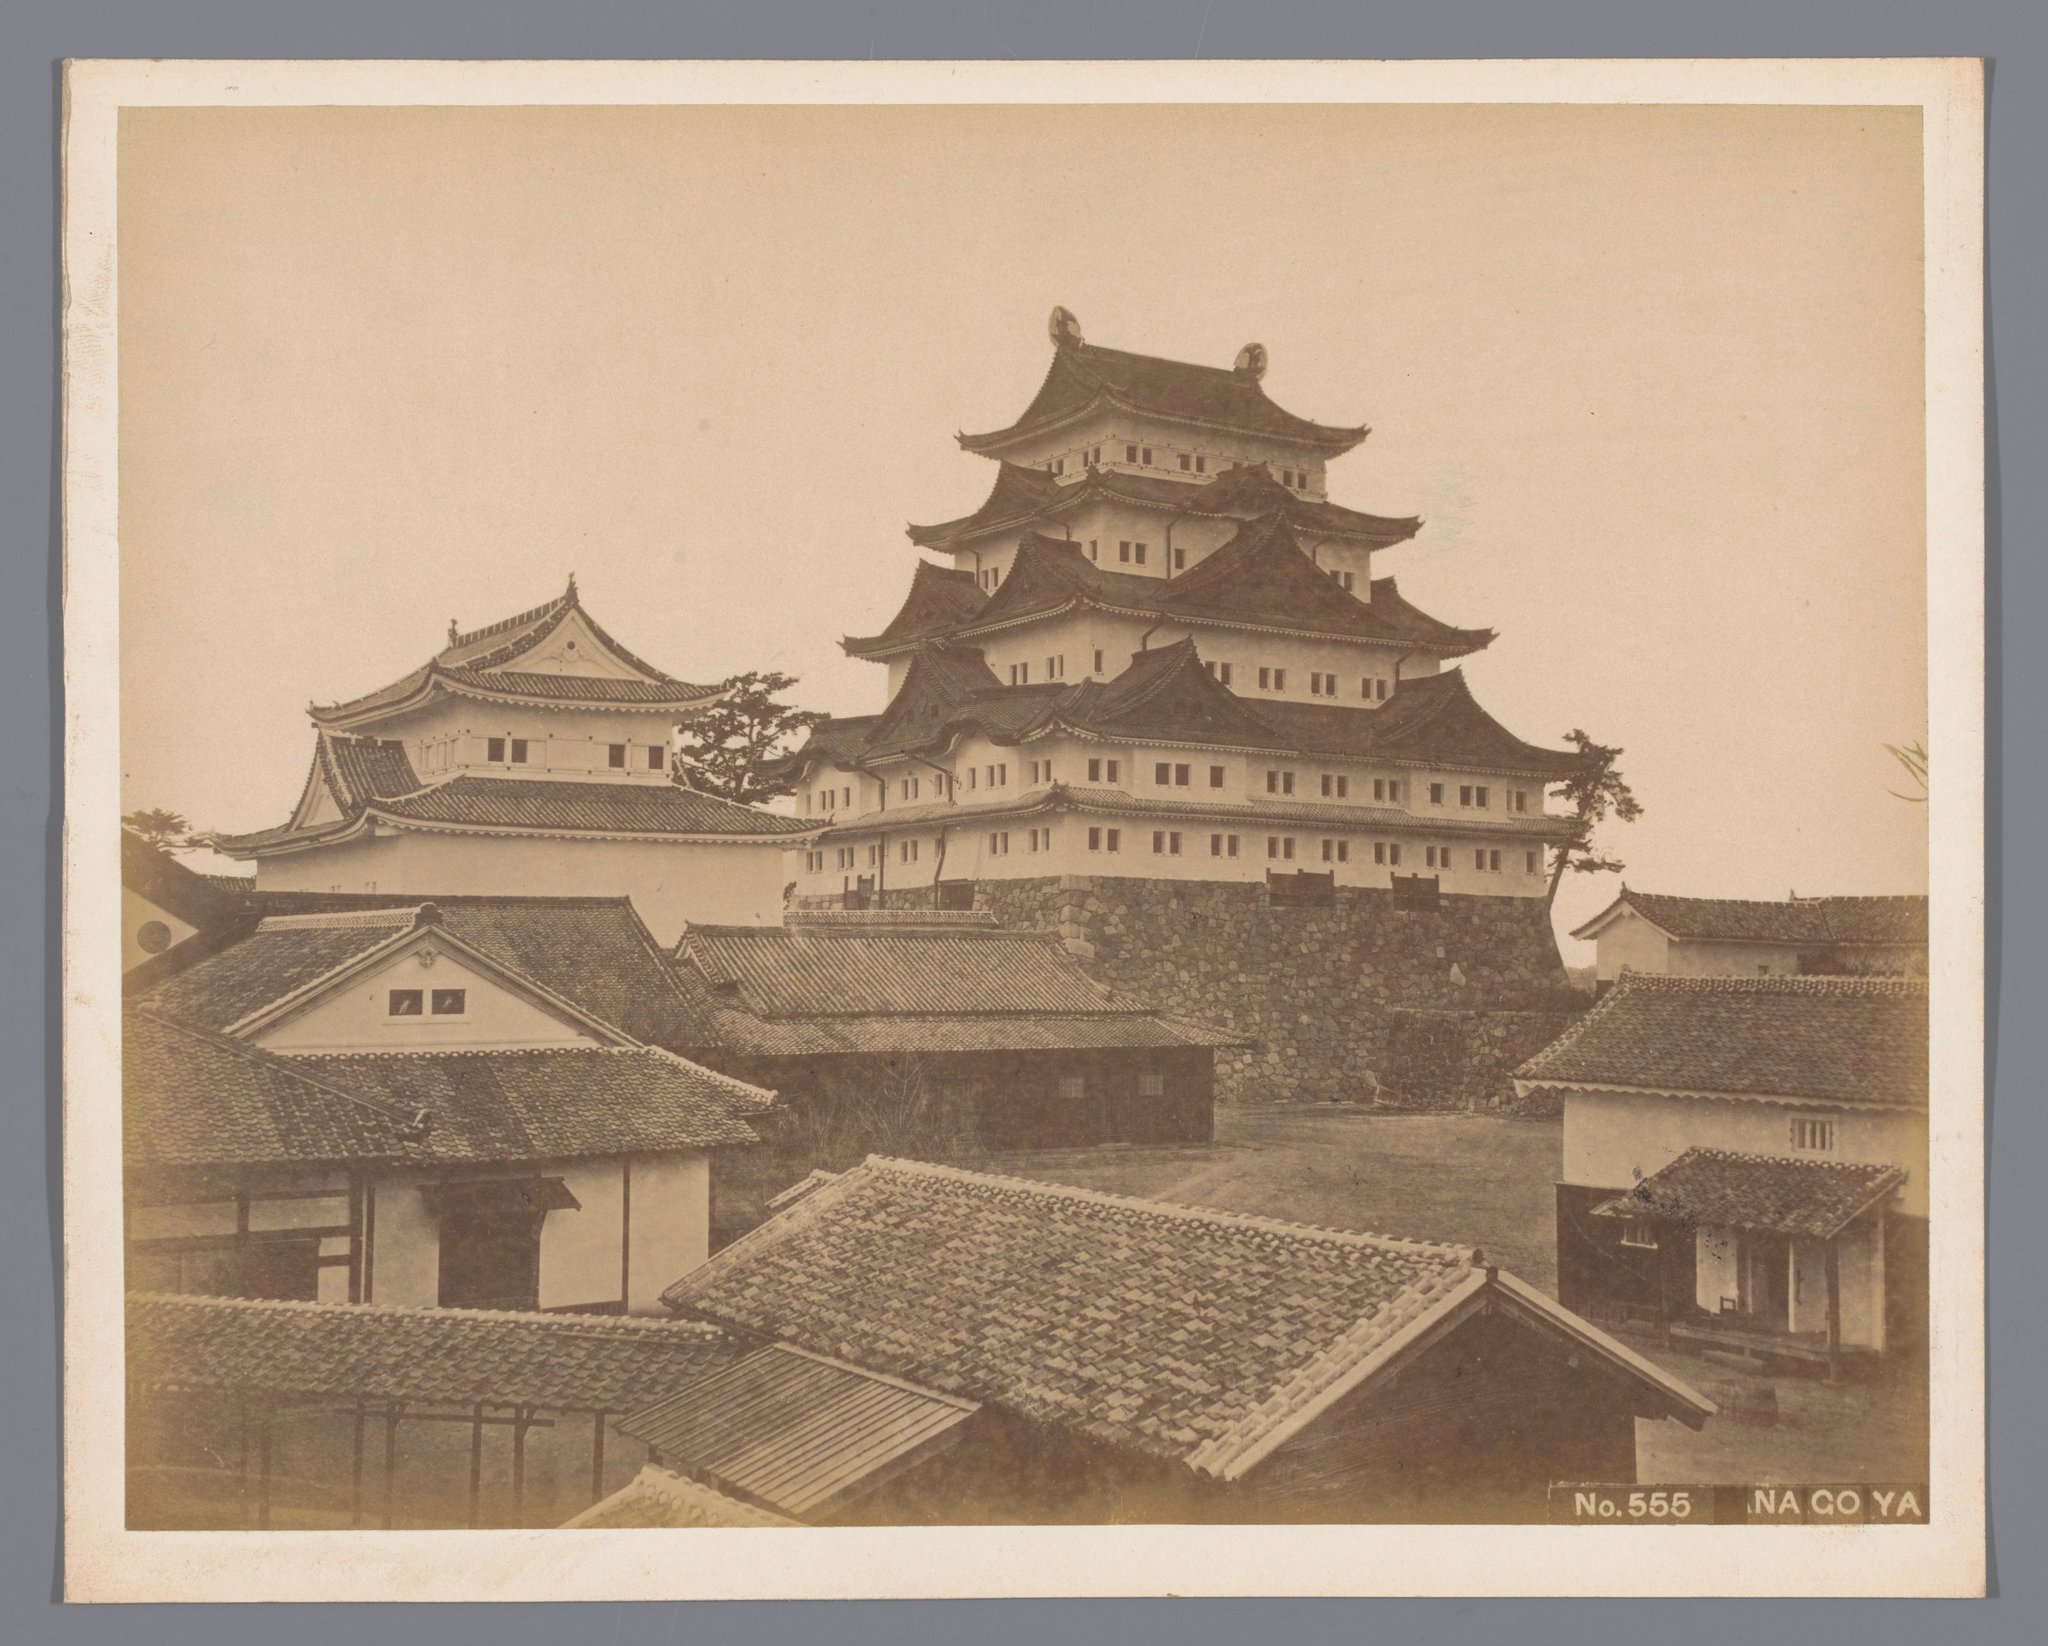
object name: photograph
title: Nagoya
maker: Anonymous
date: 1860-1900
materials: cardboard, paper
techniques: albumen print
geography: nagoya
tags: castle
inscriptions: number: ‘29’, number: ‘No. 555’